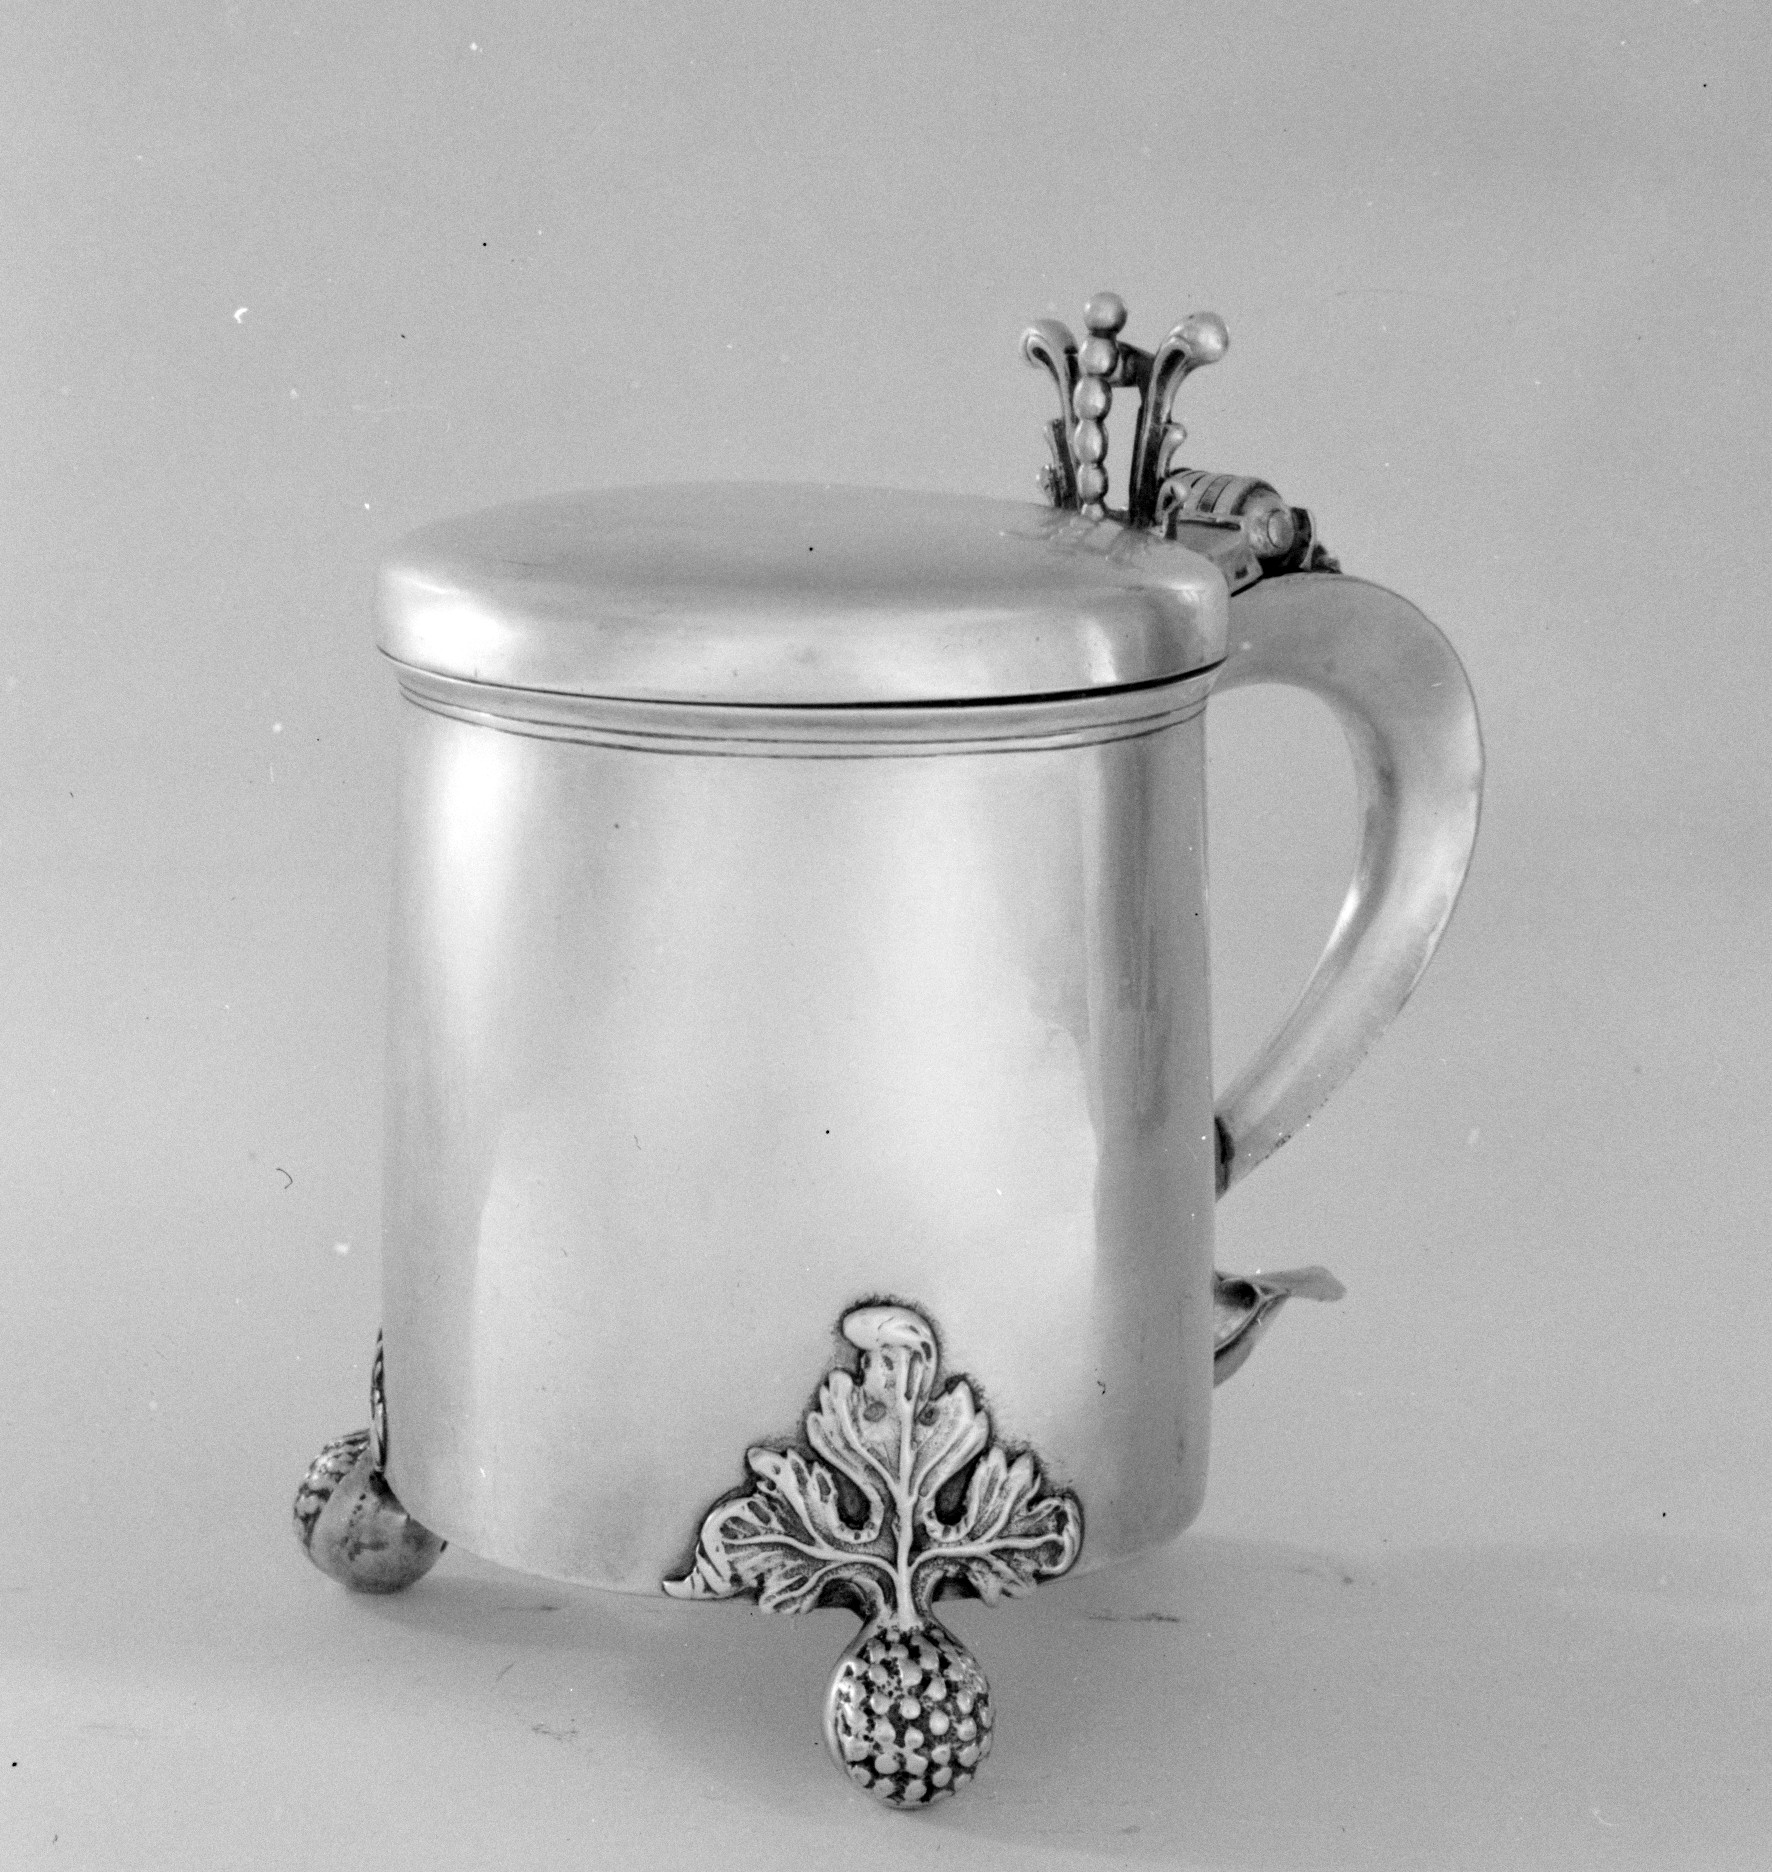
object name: tankard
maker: ? m., provincial england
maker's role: maker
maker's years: 1670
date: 1670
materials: silver